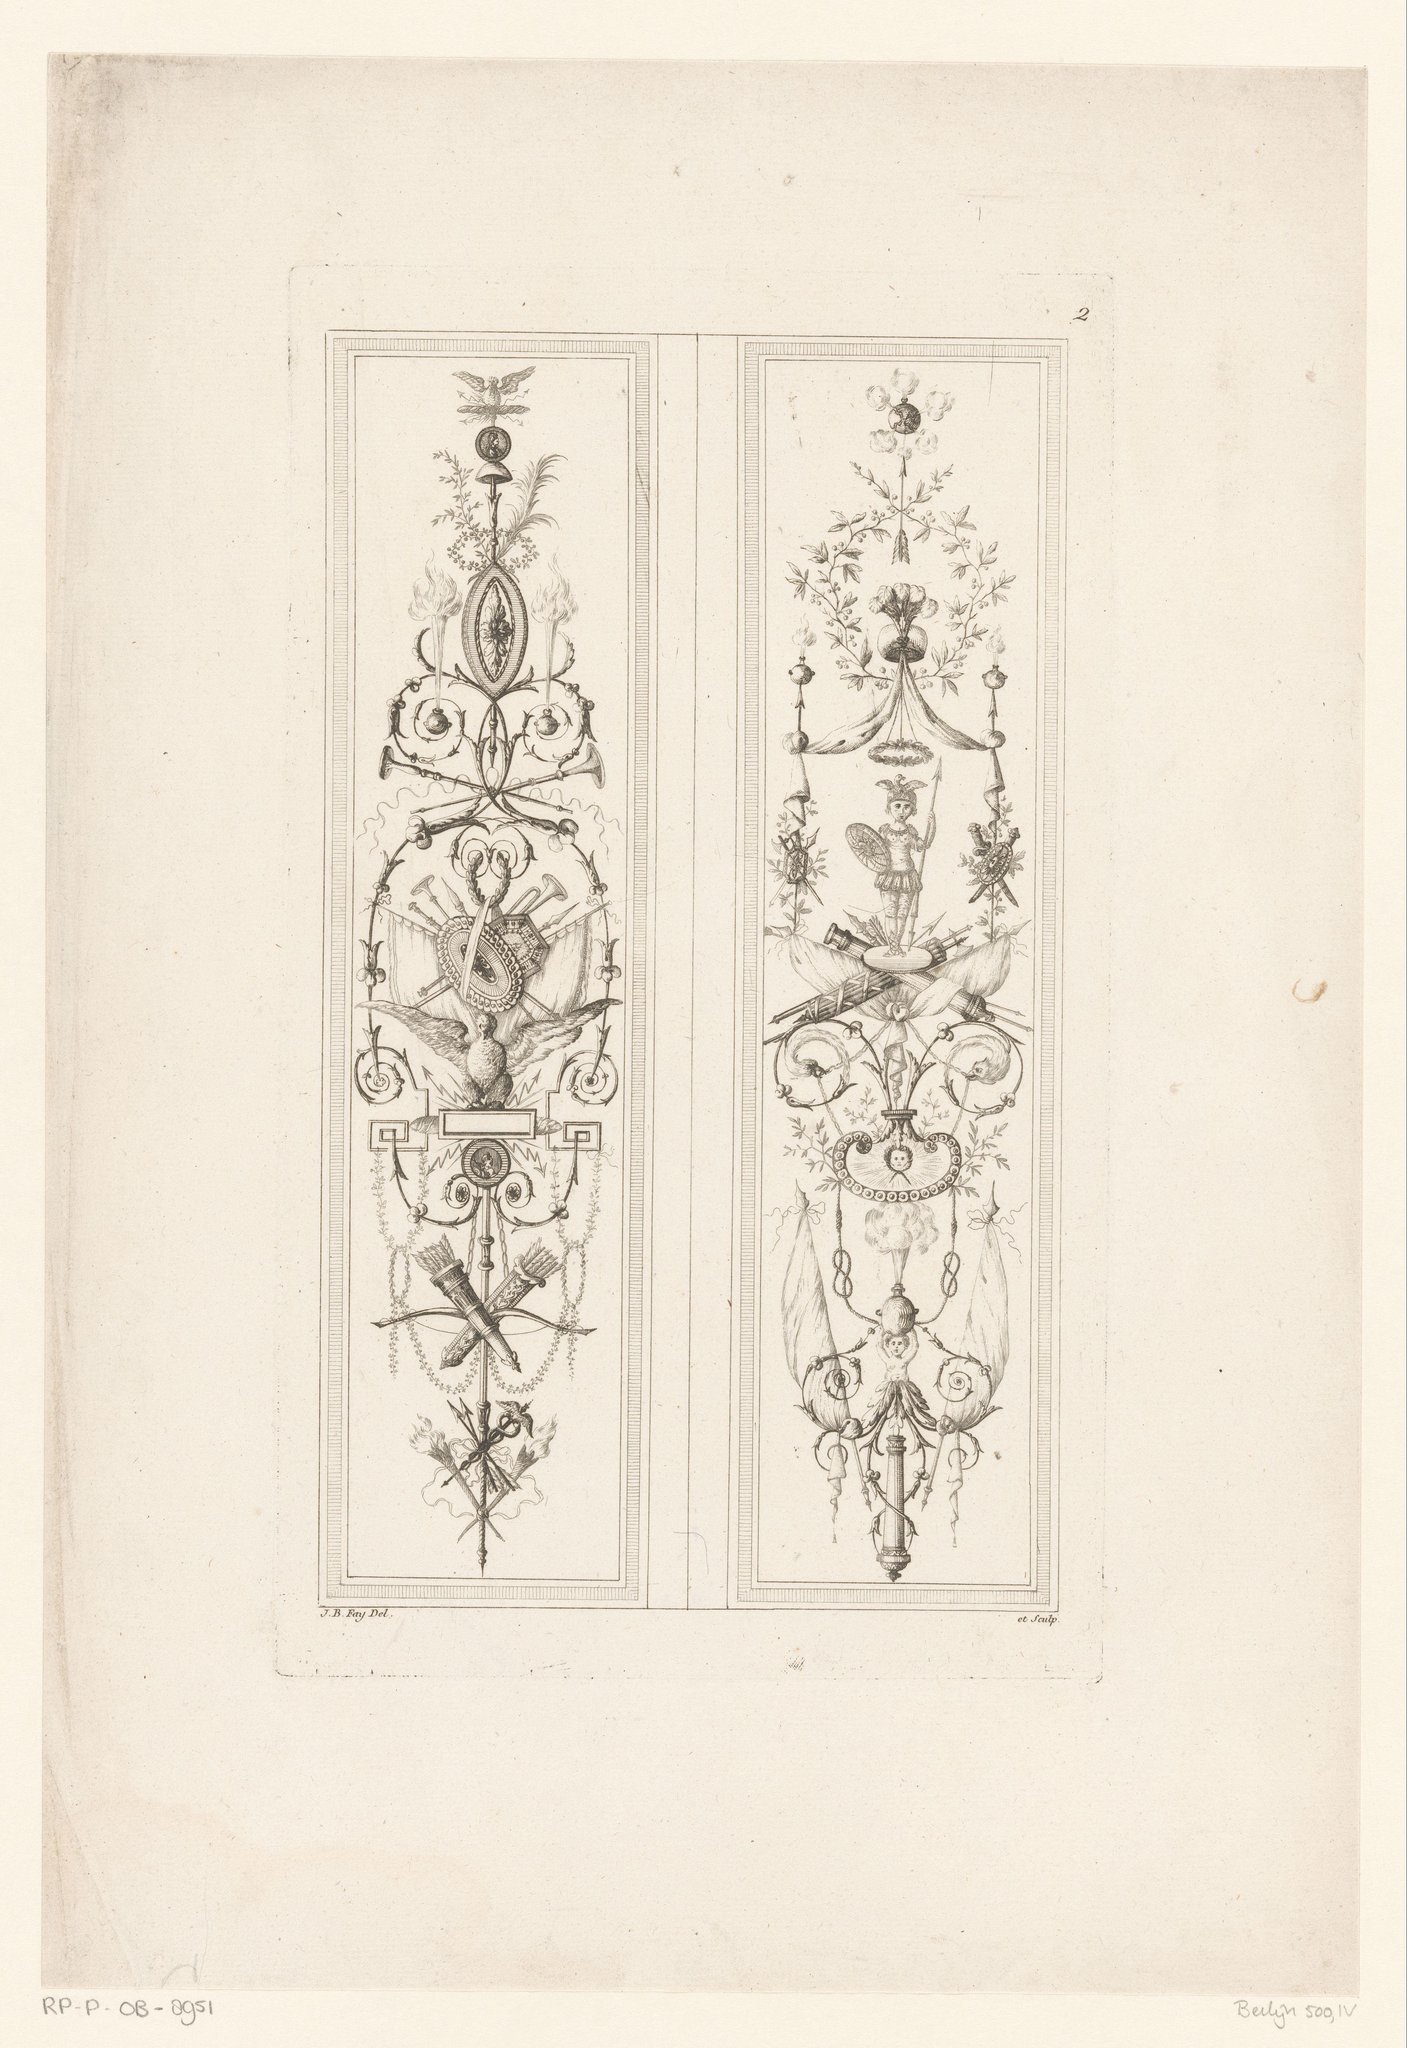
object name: print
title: IVe Cahier D'Arabesques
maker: jean baptiste fay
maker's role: print maker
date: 1784-1796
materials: paper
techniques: engraving, etching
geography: paris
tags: ornament ~ arabesque, weapons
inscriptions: collector's mark: Lugt 2228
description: Twee verticale panelen met arabesken. Links met bommen, bazuinen, schilden, lansen, een adelaar met bliksemschichten (symbolen van Jupiter), pijlenkokers en boog, fakkels en een caduceus. Rechts met bommen, pijlen, een tulband, Minerva staand op wapens, vlaggen en een kanon.